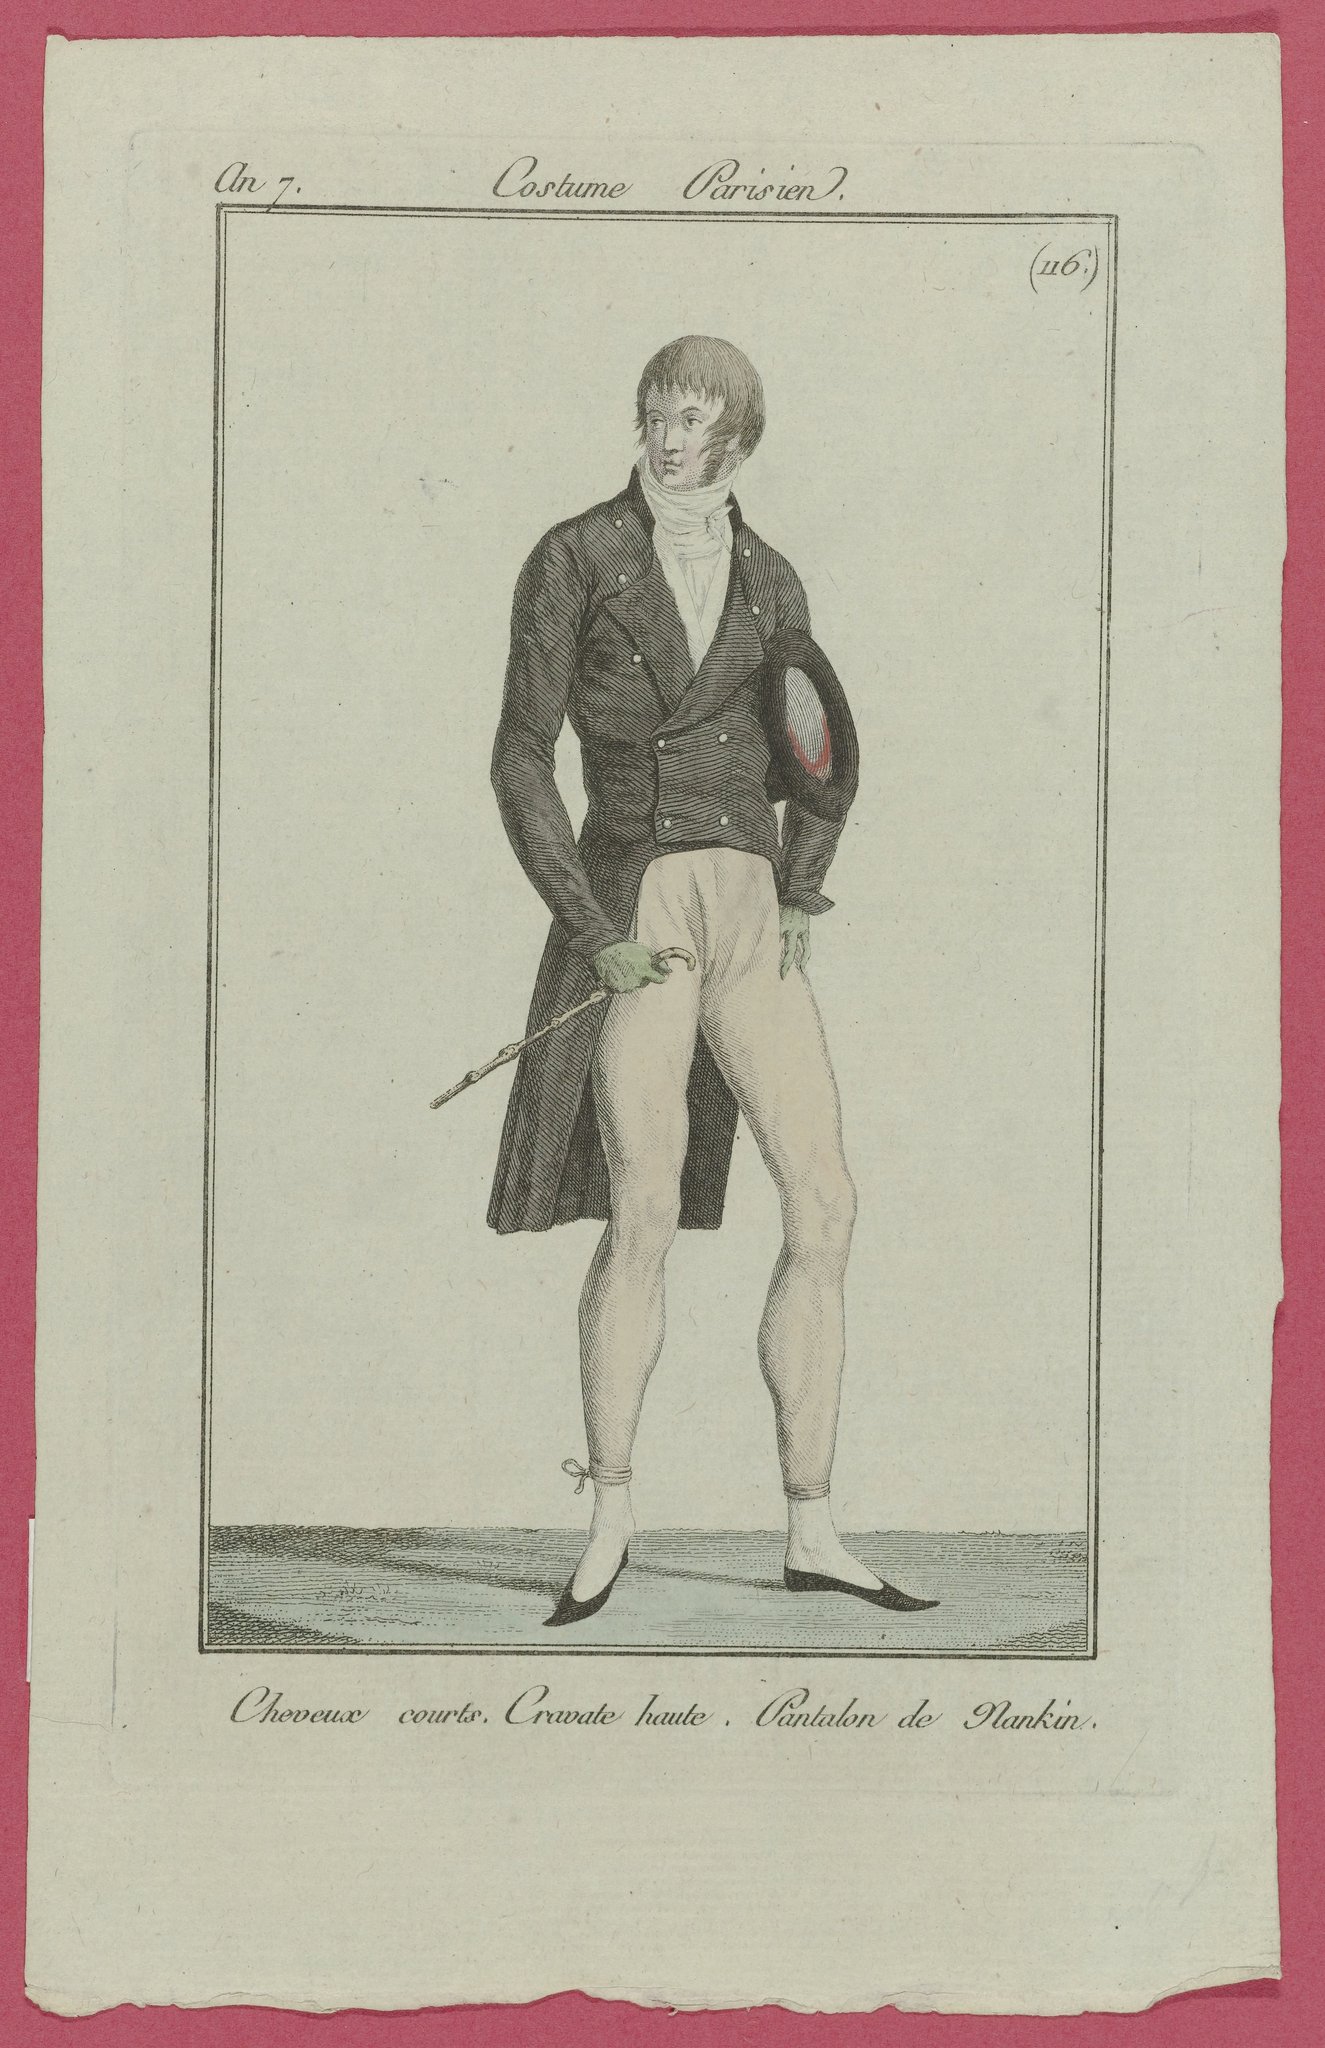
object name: fashion print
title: Journal des Dames et des Modes, Costume Parisien, 1799, An 7 (116) : Cheveux courts (...)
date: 1799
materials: paper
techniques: engraving, hand coloring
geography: paris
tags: clothing for the upper part of the body (vest) (+ men's clothes), neck-gear ~ clothing (cravat) (+ men's clothes), trousers, breeches, etc. (pantalon) (+ men's clothes), coat (+ men's clothes), styles of hairdress, fashion plates, shoes, sandals (+ men's clothes), gloves, mittens, etc. (+ men's clothes), stockings, socks (+ men's clothes)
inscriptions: title: ‘Costume Parisien.’, caption: ‘Cheveux courts. Cravate haute. Pantalon de Nankin.’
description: Kort kapsel met bakkebaarden. Om de hals een hoge cravate. Jas met een dubbele rij knopen en overslag, vest en lange broek van 'Nankin'. Accessoires: hoed onder de arm, handschoenen, kleine wandelstok, platte schoenen met puntige neuzen. De prent maakt deel uit van het modetijdschrift Journal des Dames et des Modes, uitgegeven door Pierre de la Mésangère, Parijs, 1797-1839.